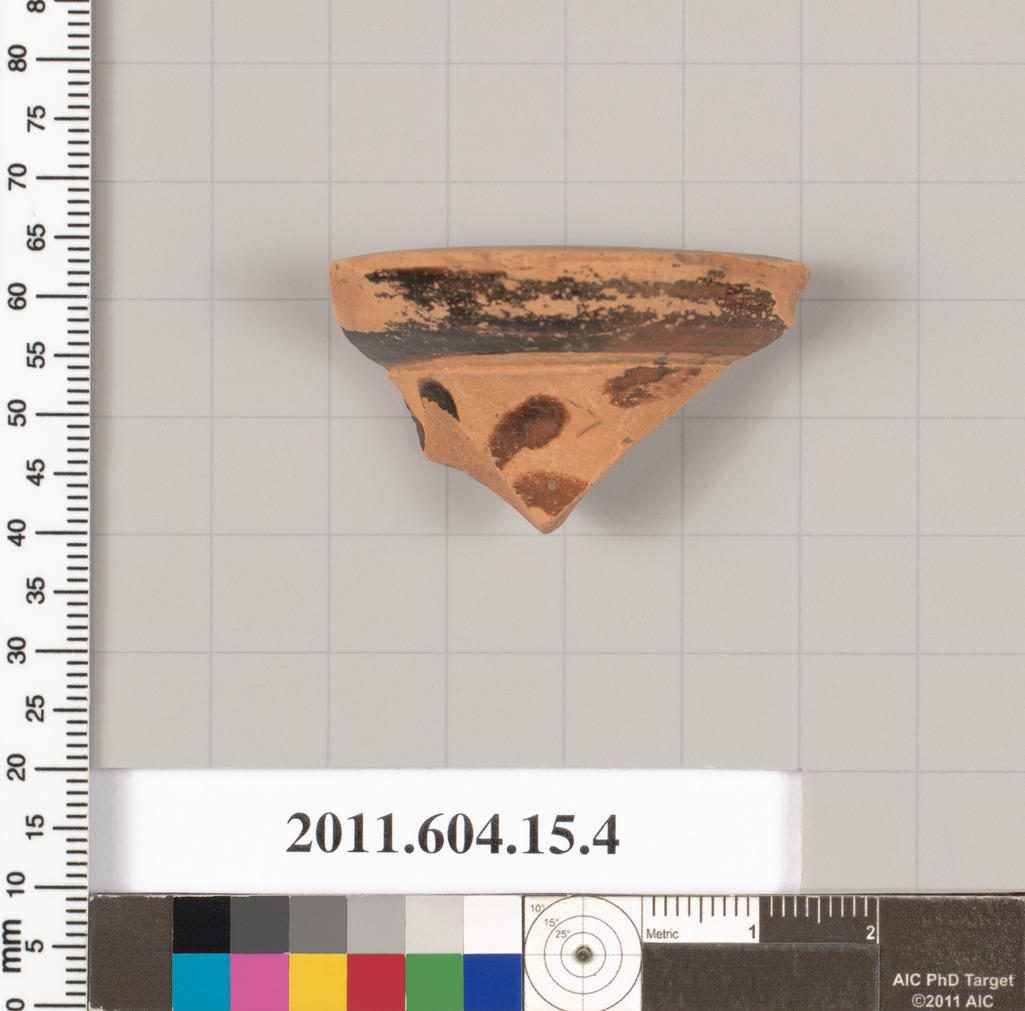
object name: amphora fragment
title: Terracotta fragment of an amphora (jar)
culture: greek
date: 534-468 BCE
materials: terracotta